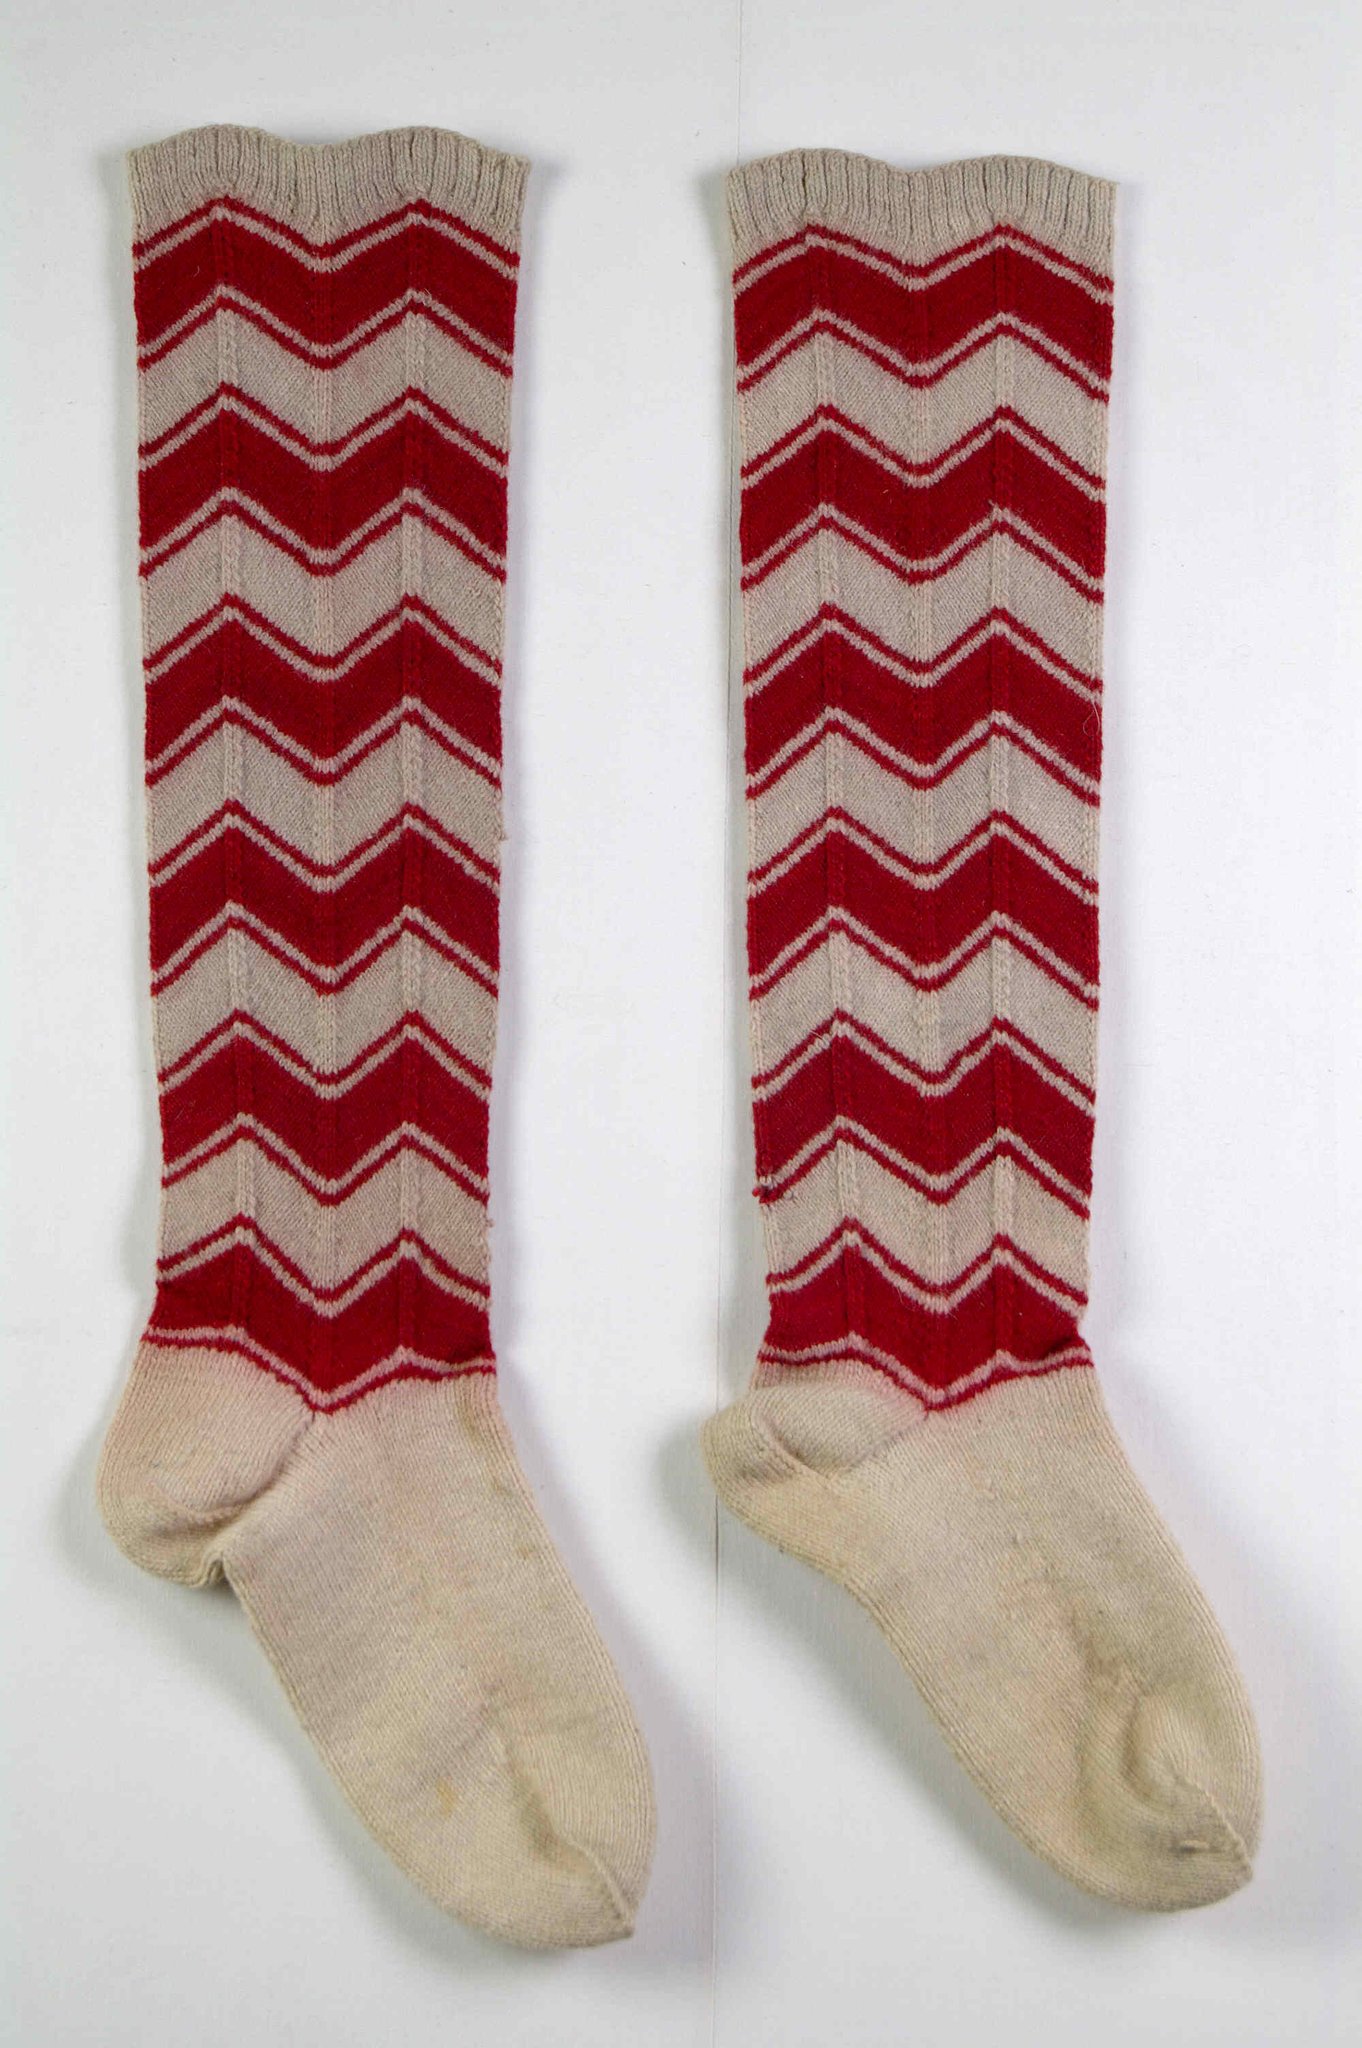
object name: stocking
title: Stockings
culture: american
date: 1851-1875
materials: wool